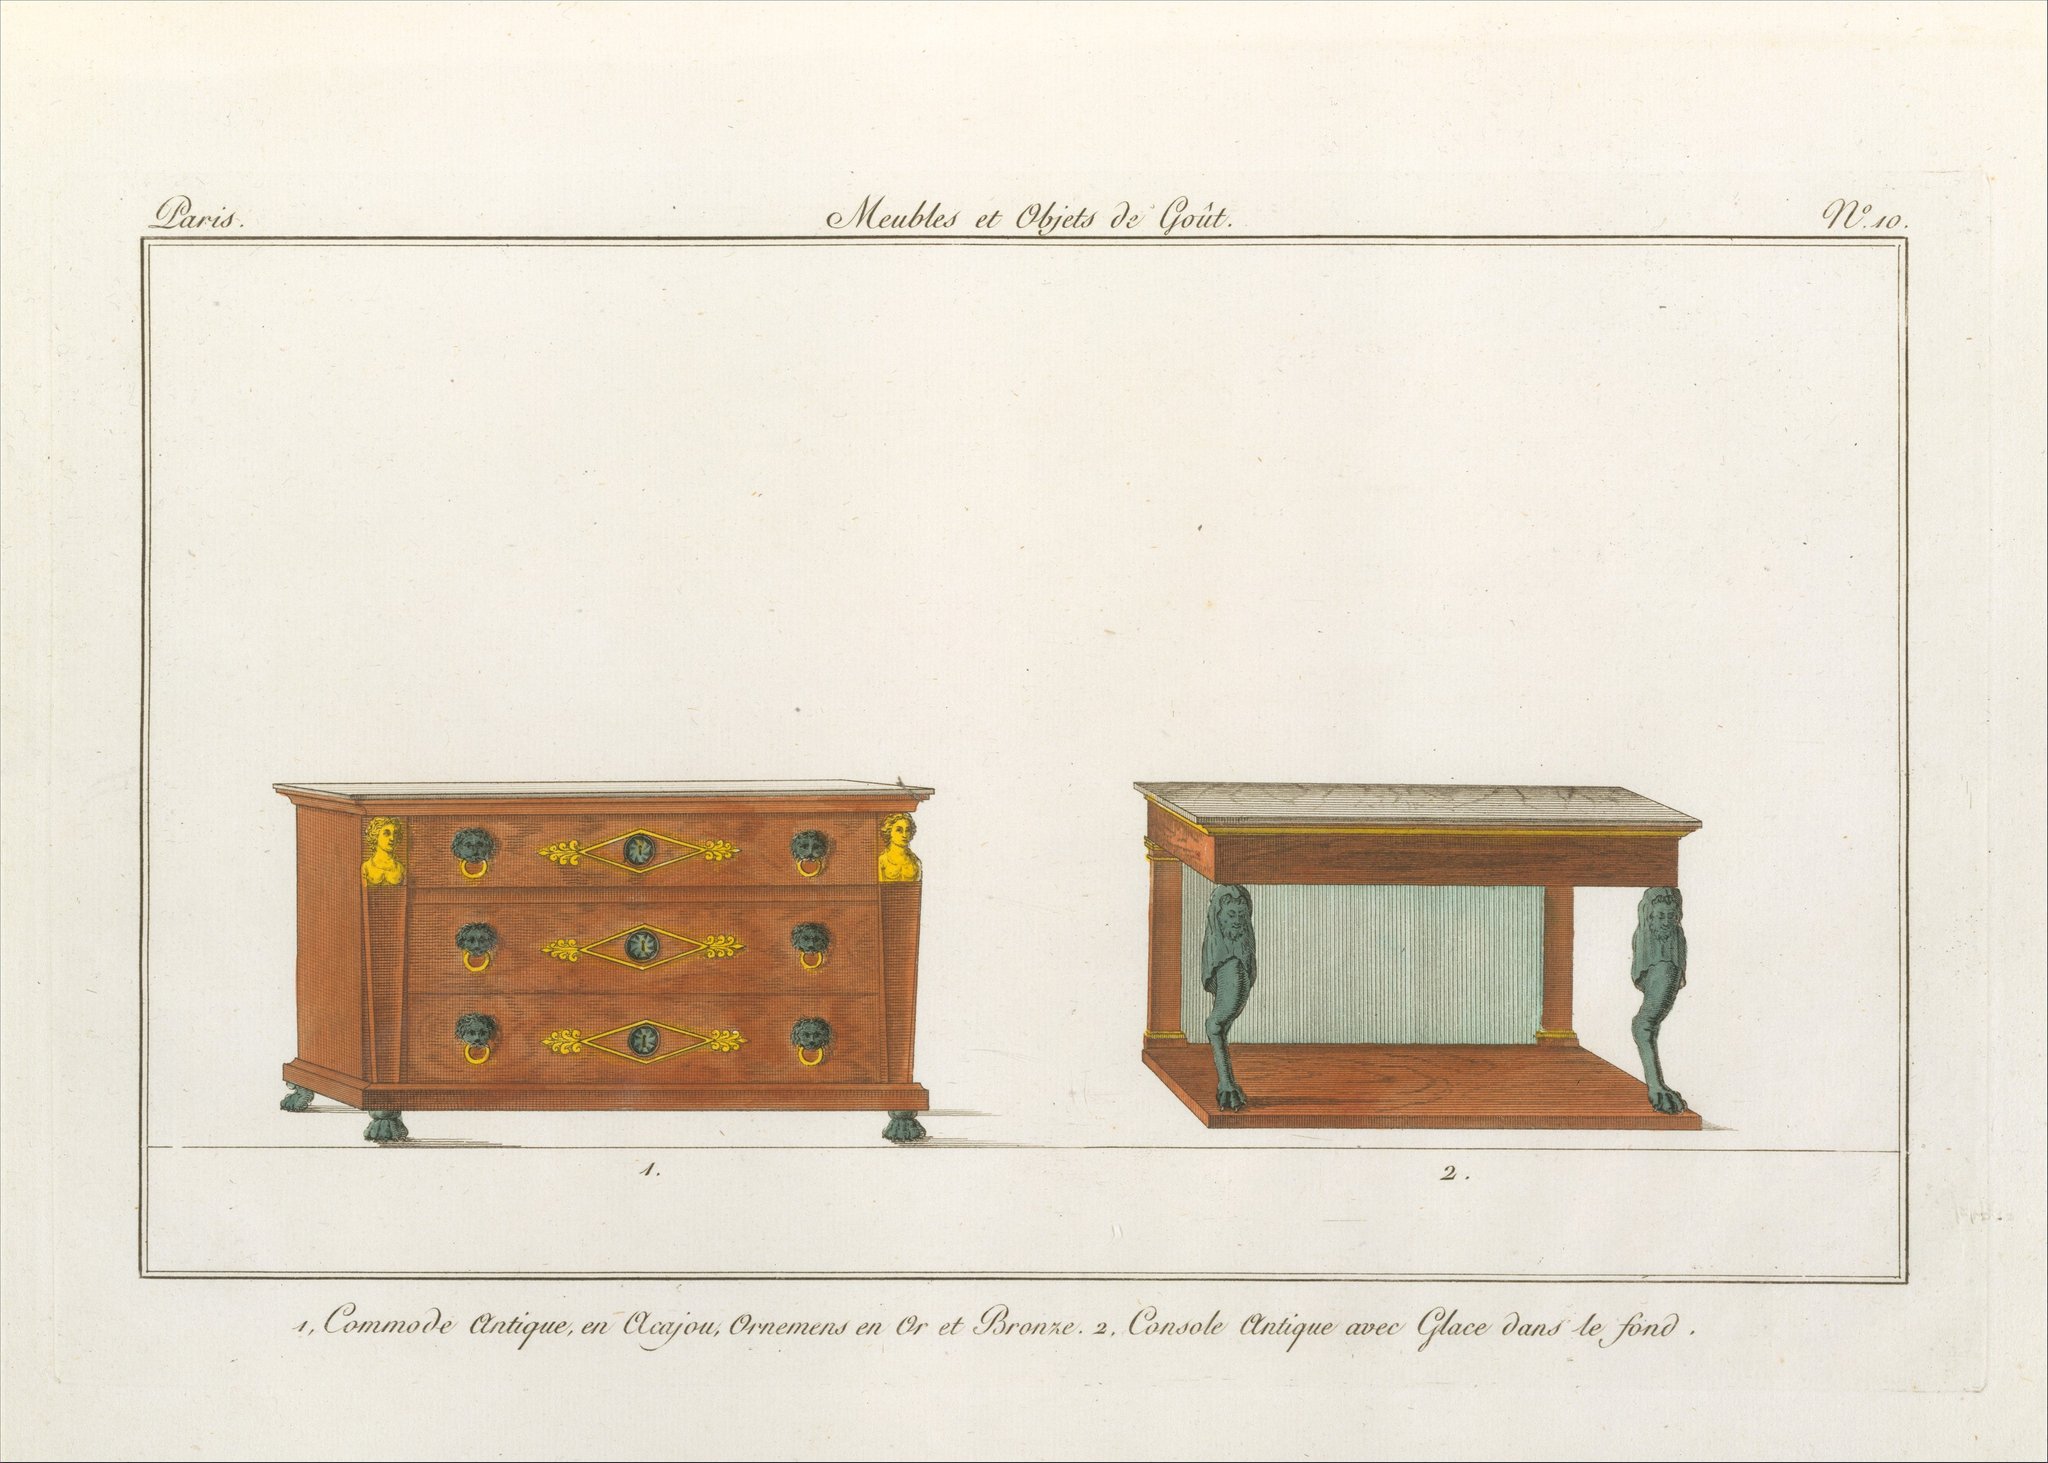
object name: book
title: Design for a Commode and Console (Plate 10), in Collection de Meubles et Objets de Goût, vol. 1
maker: pierre de la mésangère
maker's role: editor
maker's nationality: french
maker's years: 1761-1831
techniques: engraving, hand coloring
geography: france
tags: commodes